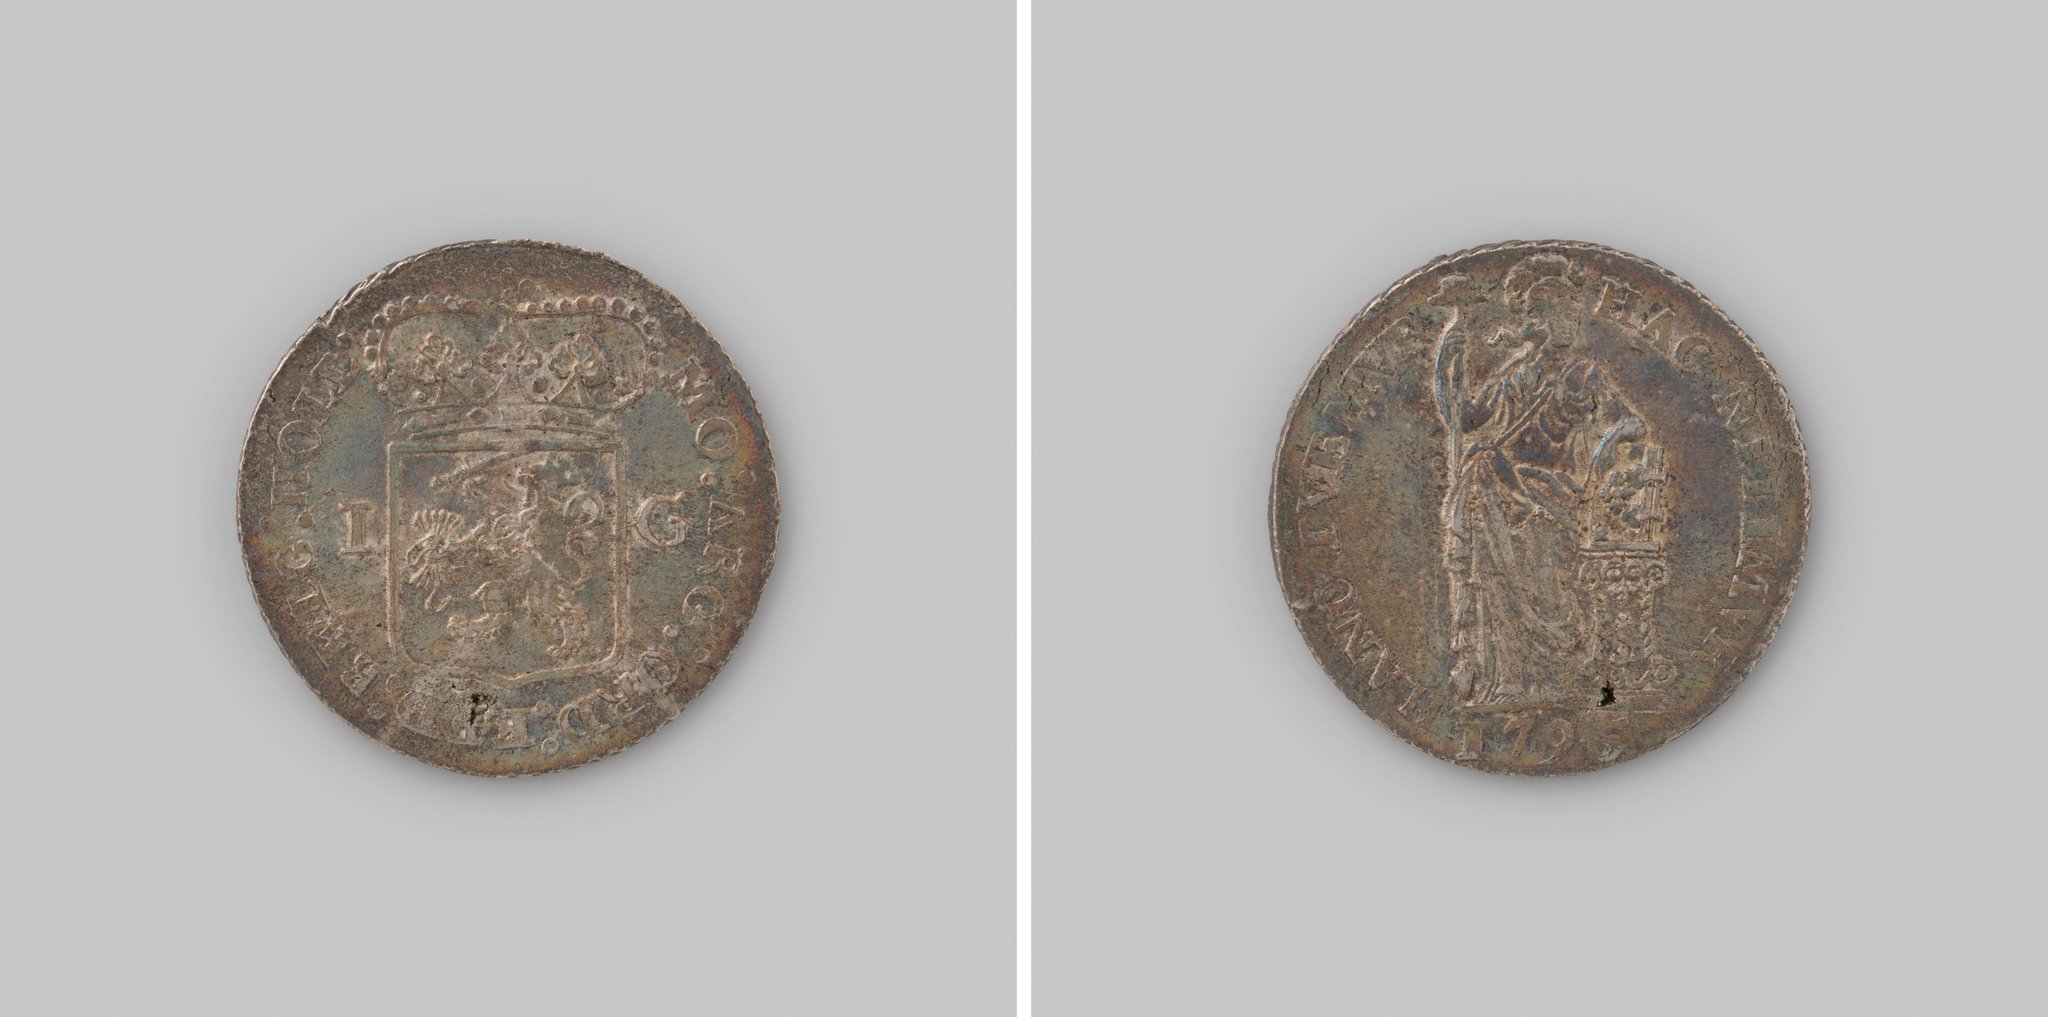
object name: gulden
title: Zilveren gulden uit 1795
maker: Anonymous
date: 1795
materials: silver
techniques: striking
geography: netherlands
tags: utrecht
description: Een gulden van zilver uit 1795, gemaakt in Holland